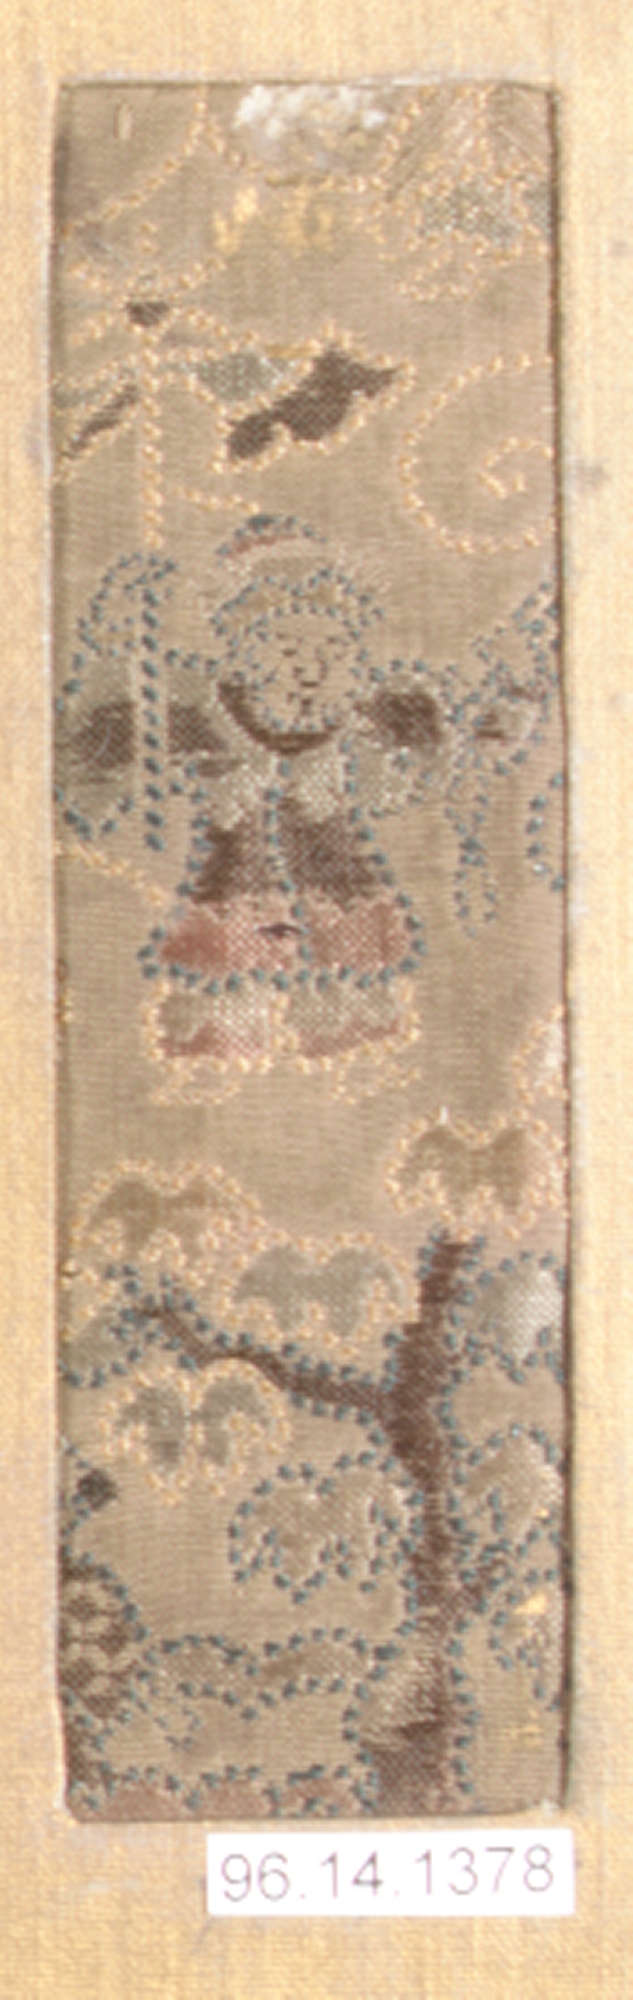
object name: piece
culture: japanese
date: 1701-1900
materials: silk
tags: human figures